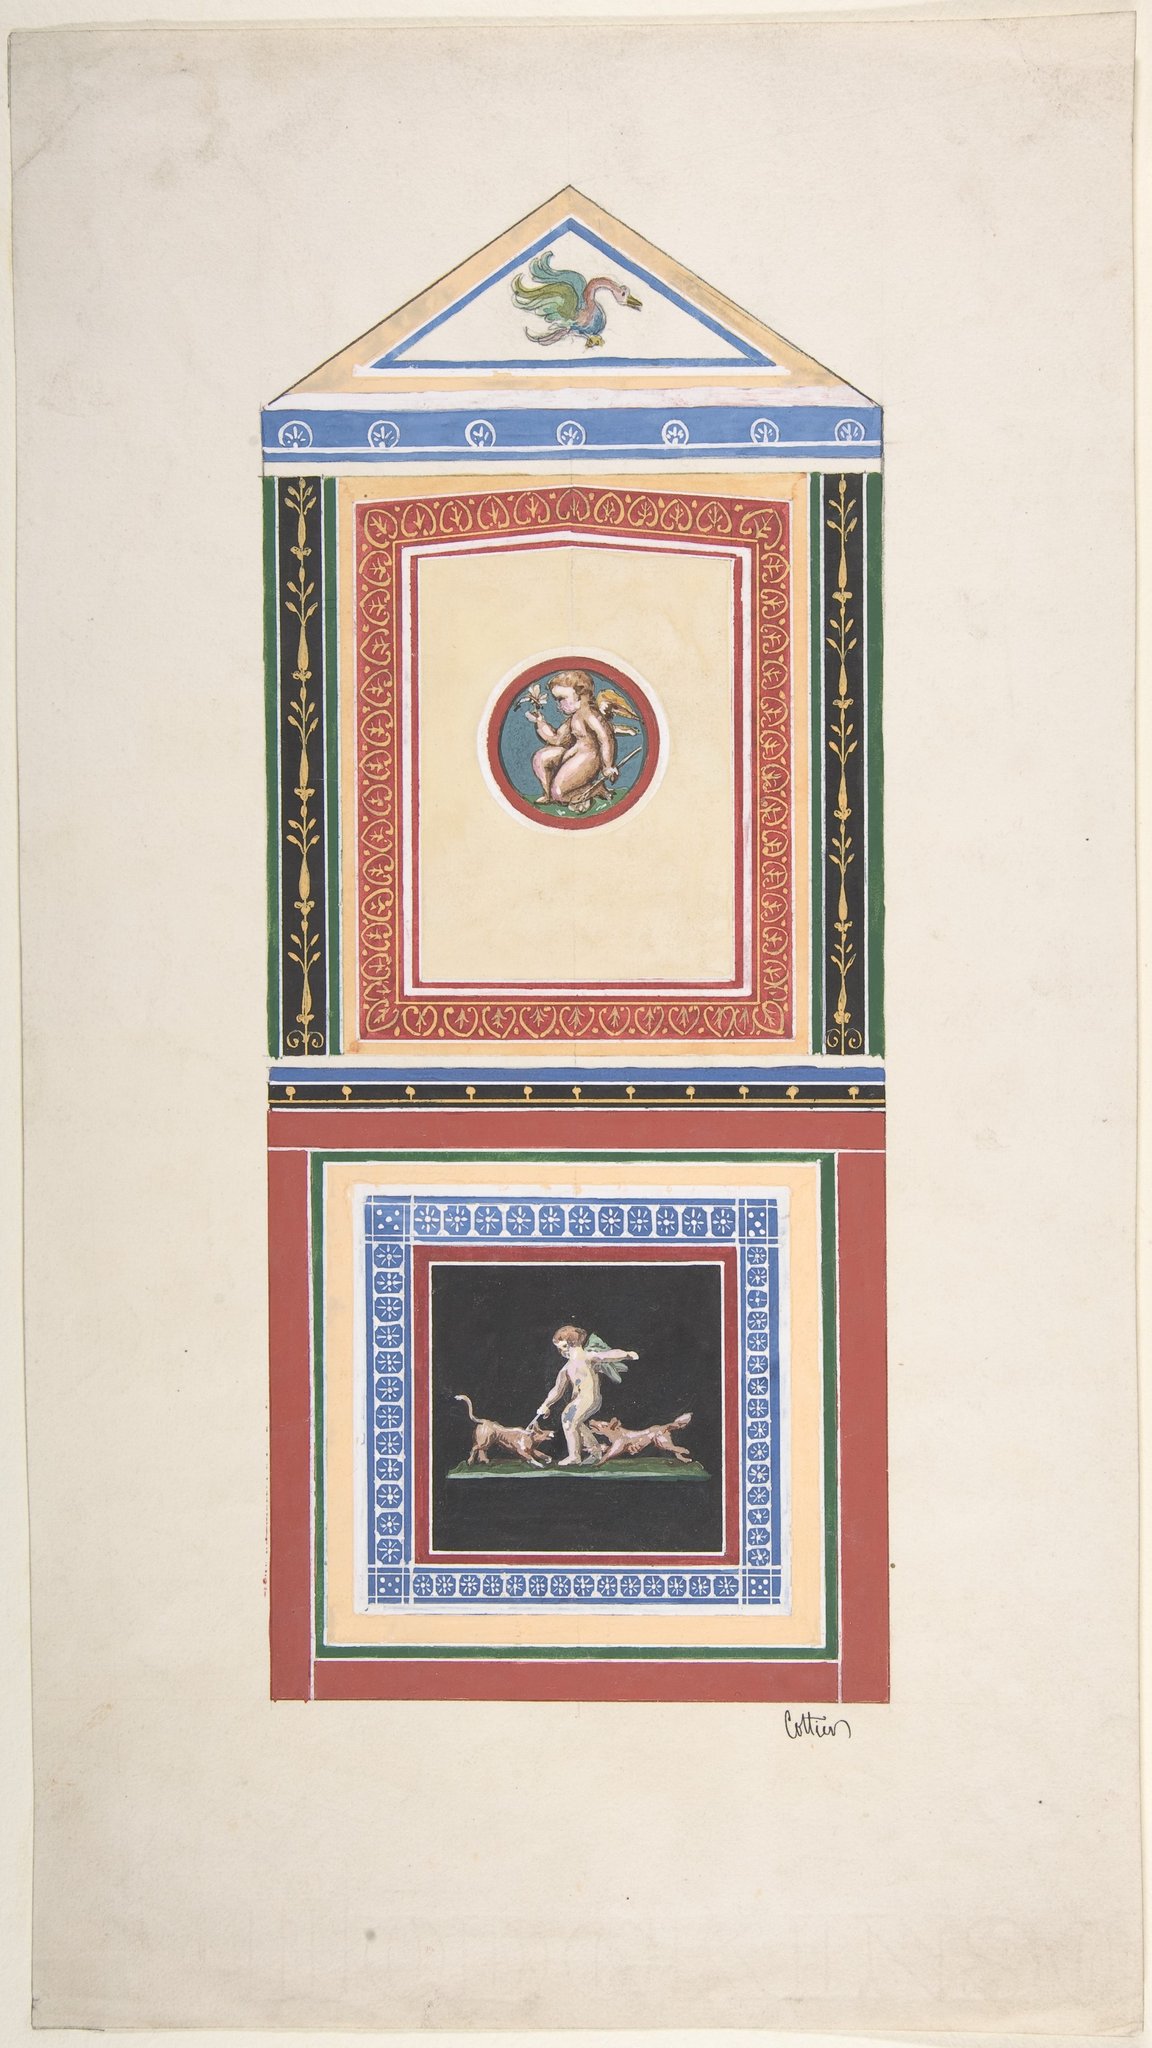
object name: drawing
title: Design for Wall Decor Painted with Putti and Dogs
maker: jules-edmond-charles lachaise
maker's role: artist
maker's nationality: french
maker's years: 1897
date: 1889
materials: gouache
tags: dogs